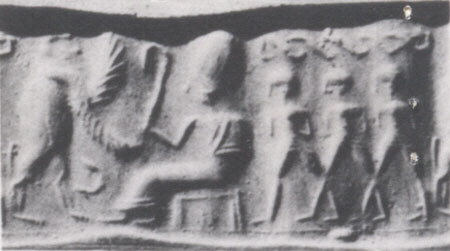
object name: cylinder seal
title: Cylinder seal and modern impression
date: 1720-1650 BCE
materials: mineral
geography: syria